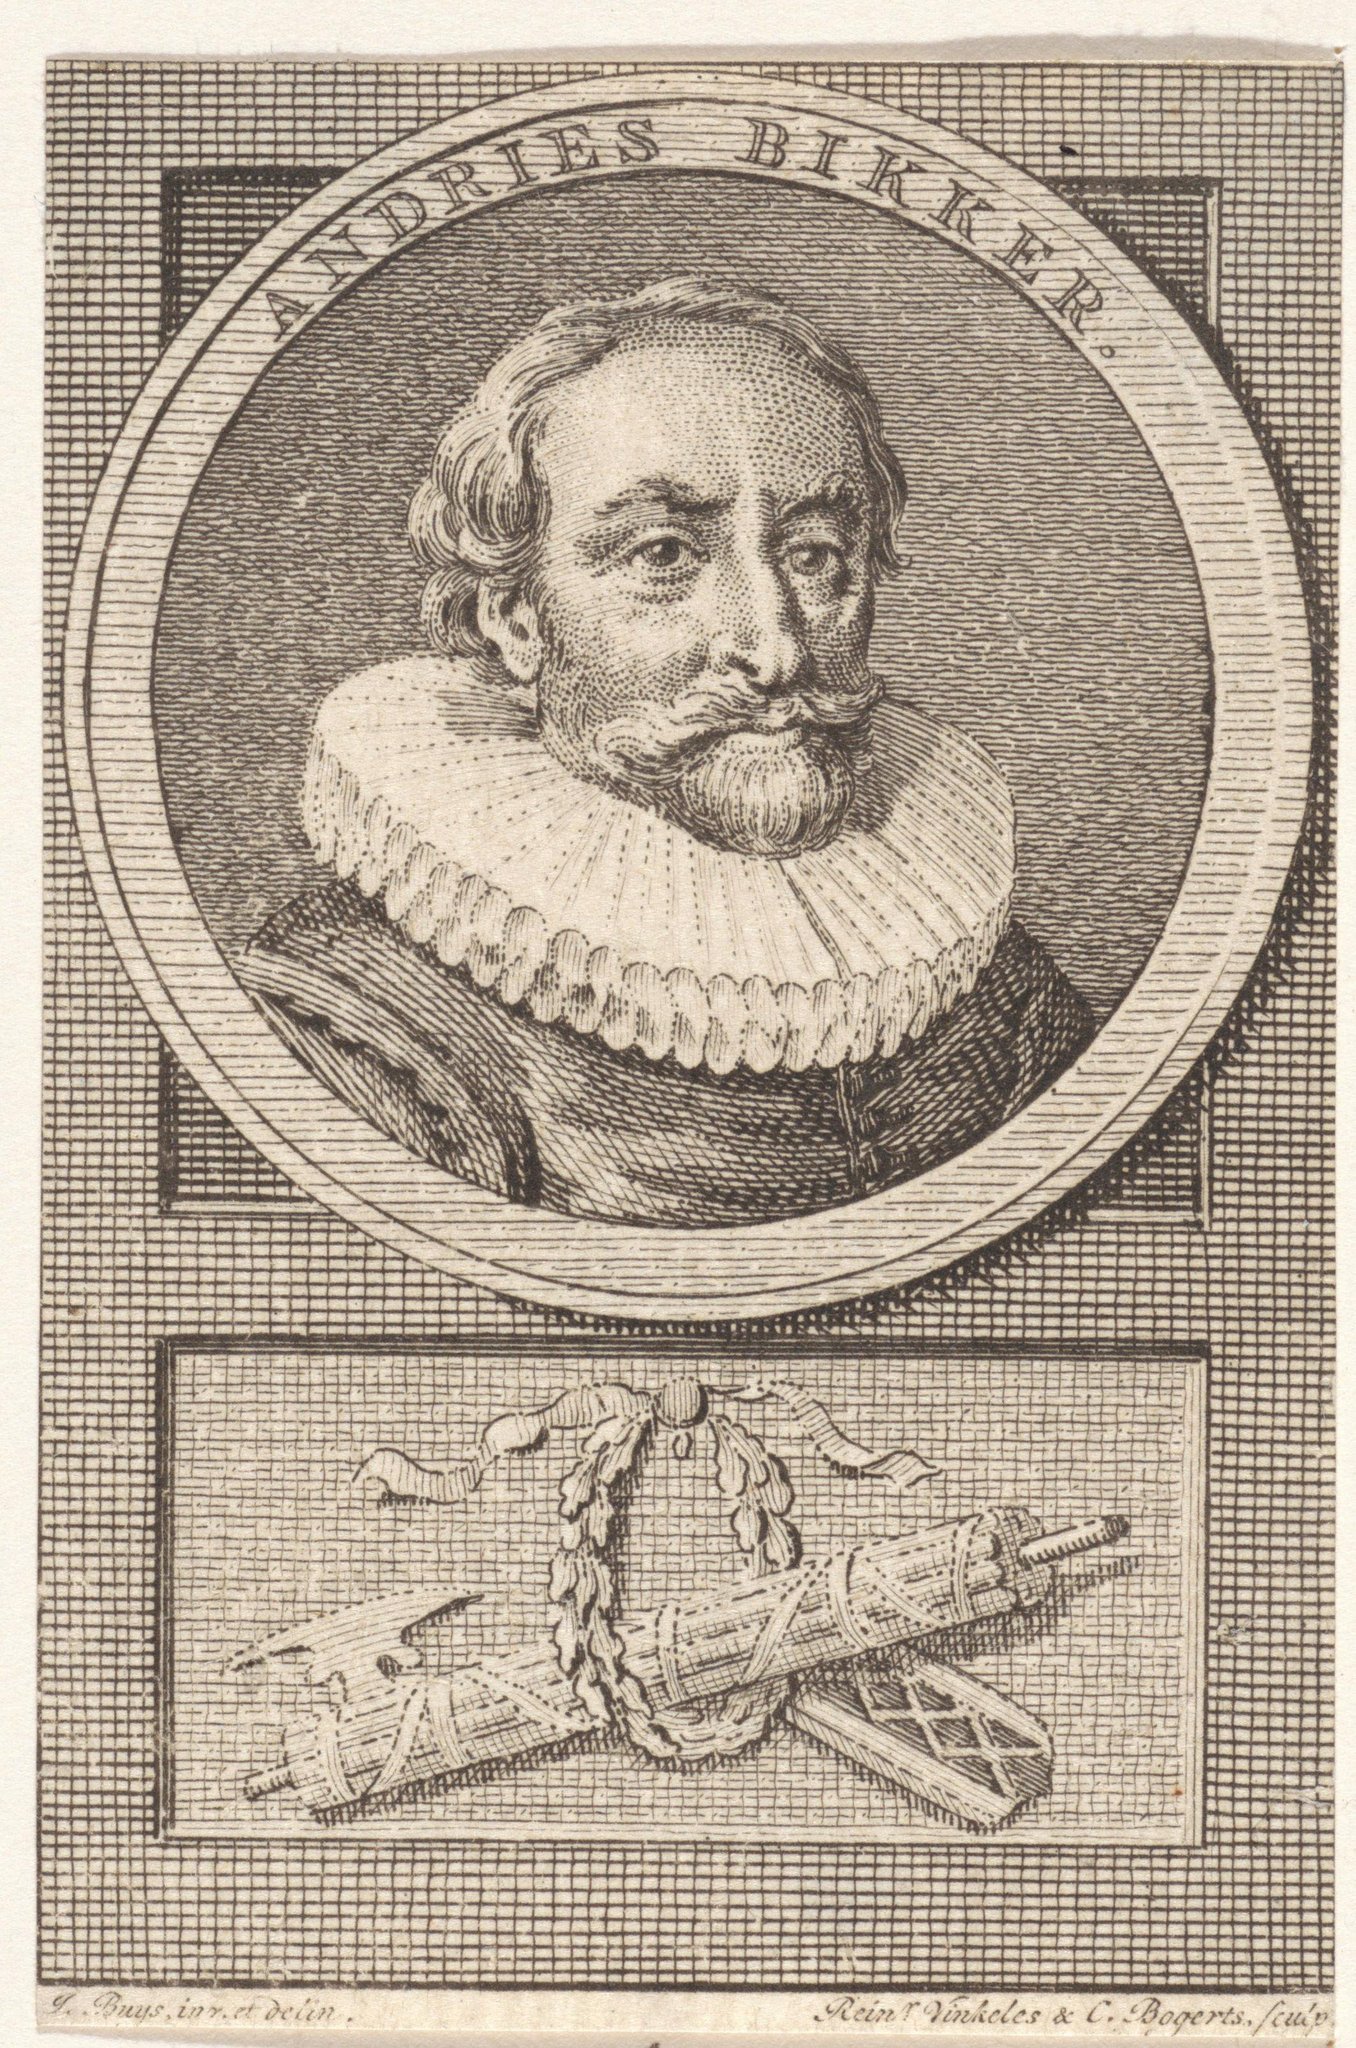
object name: print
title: Portret van Andries Bicker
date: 1783-1795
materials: paper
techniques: engraving, etching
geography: amsterdam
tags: koopman, regent, andries bicker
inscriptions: collector's mark: Lugt 2228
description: Prent gebruikt in: Fokke, Jan. Geschiedenissen der Vereenigde Nederlanden voor de vaderlandsche jeugd Ie-XXVste deel. Amsterdam: Johannes Allart, 1783-1795. Deel VIII.